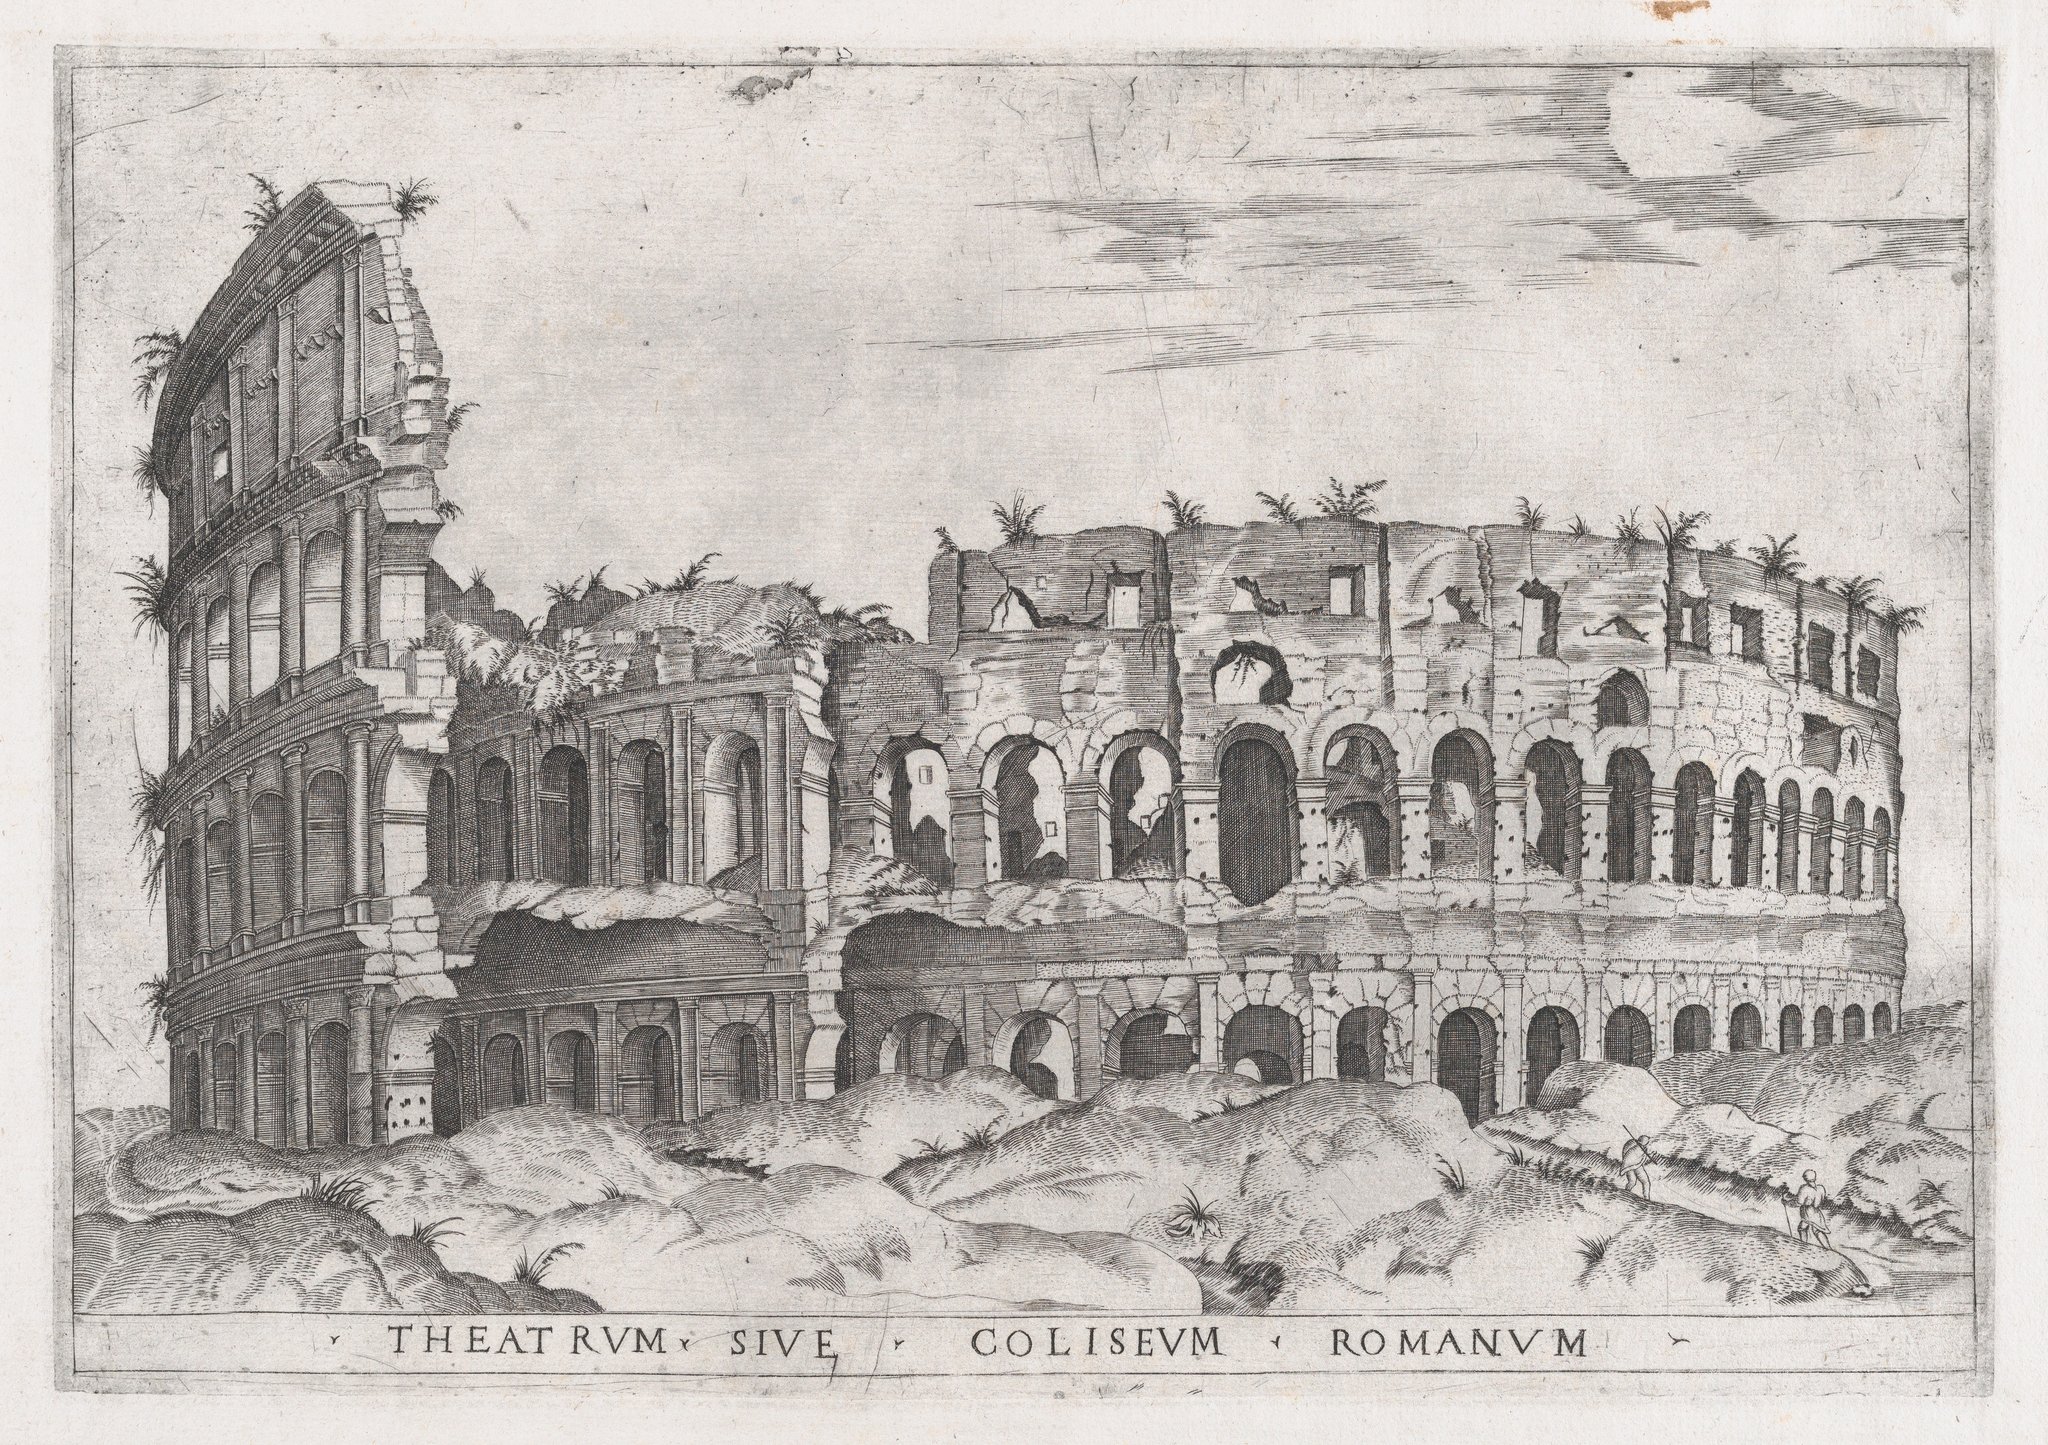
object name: print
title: The Colosseum, from "Speculum Romanae Magnificentiae"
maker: Anonymous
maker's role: artist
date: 1501-1600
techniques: engraving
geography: rome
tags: architecture,ruins,rome